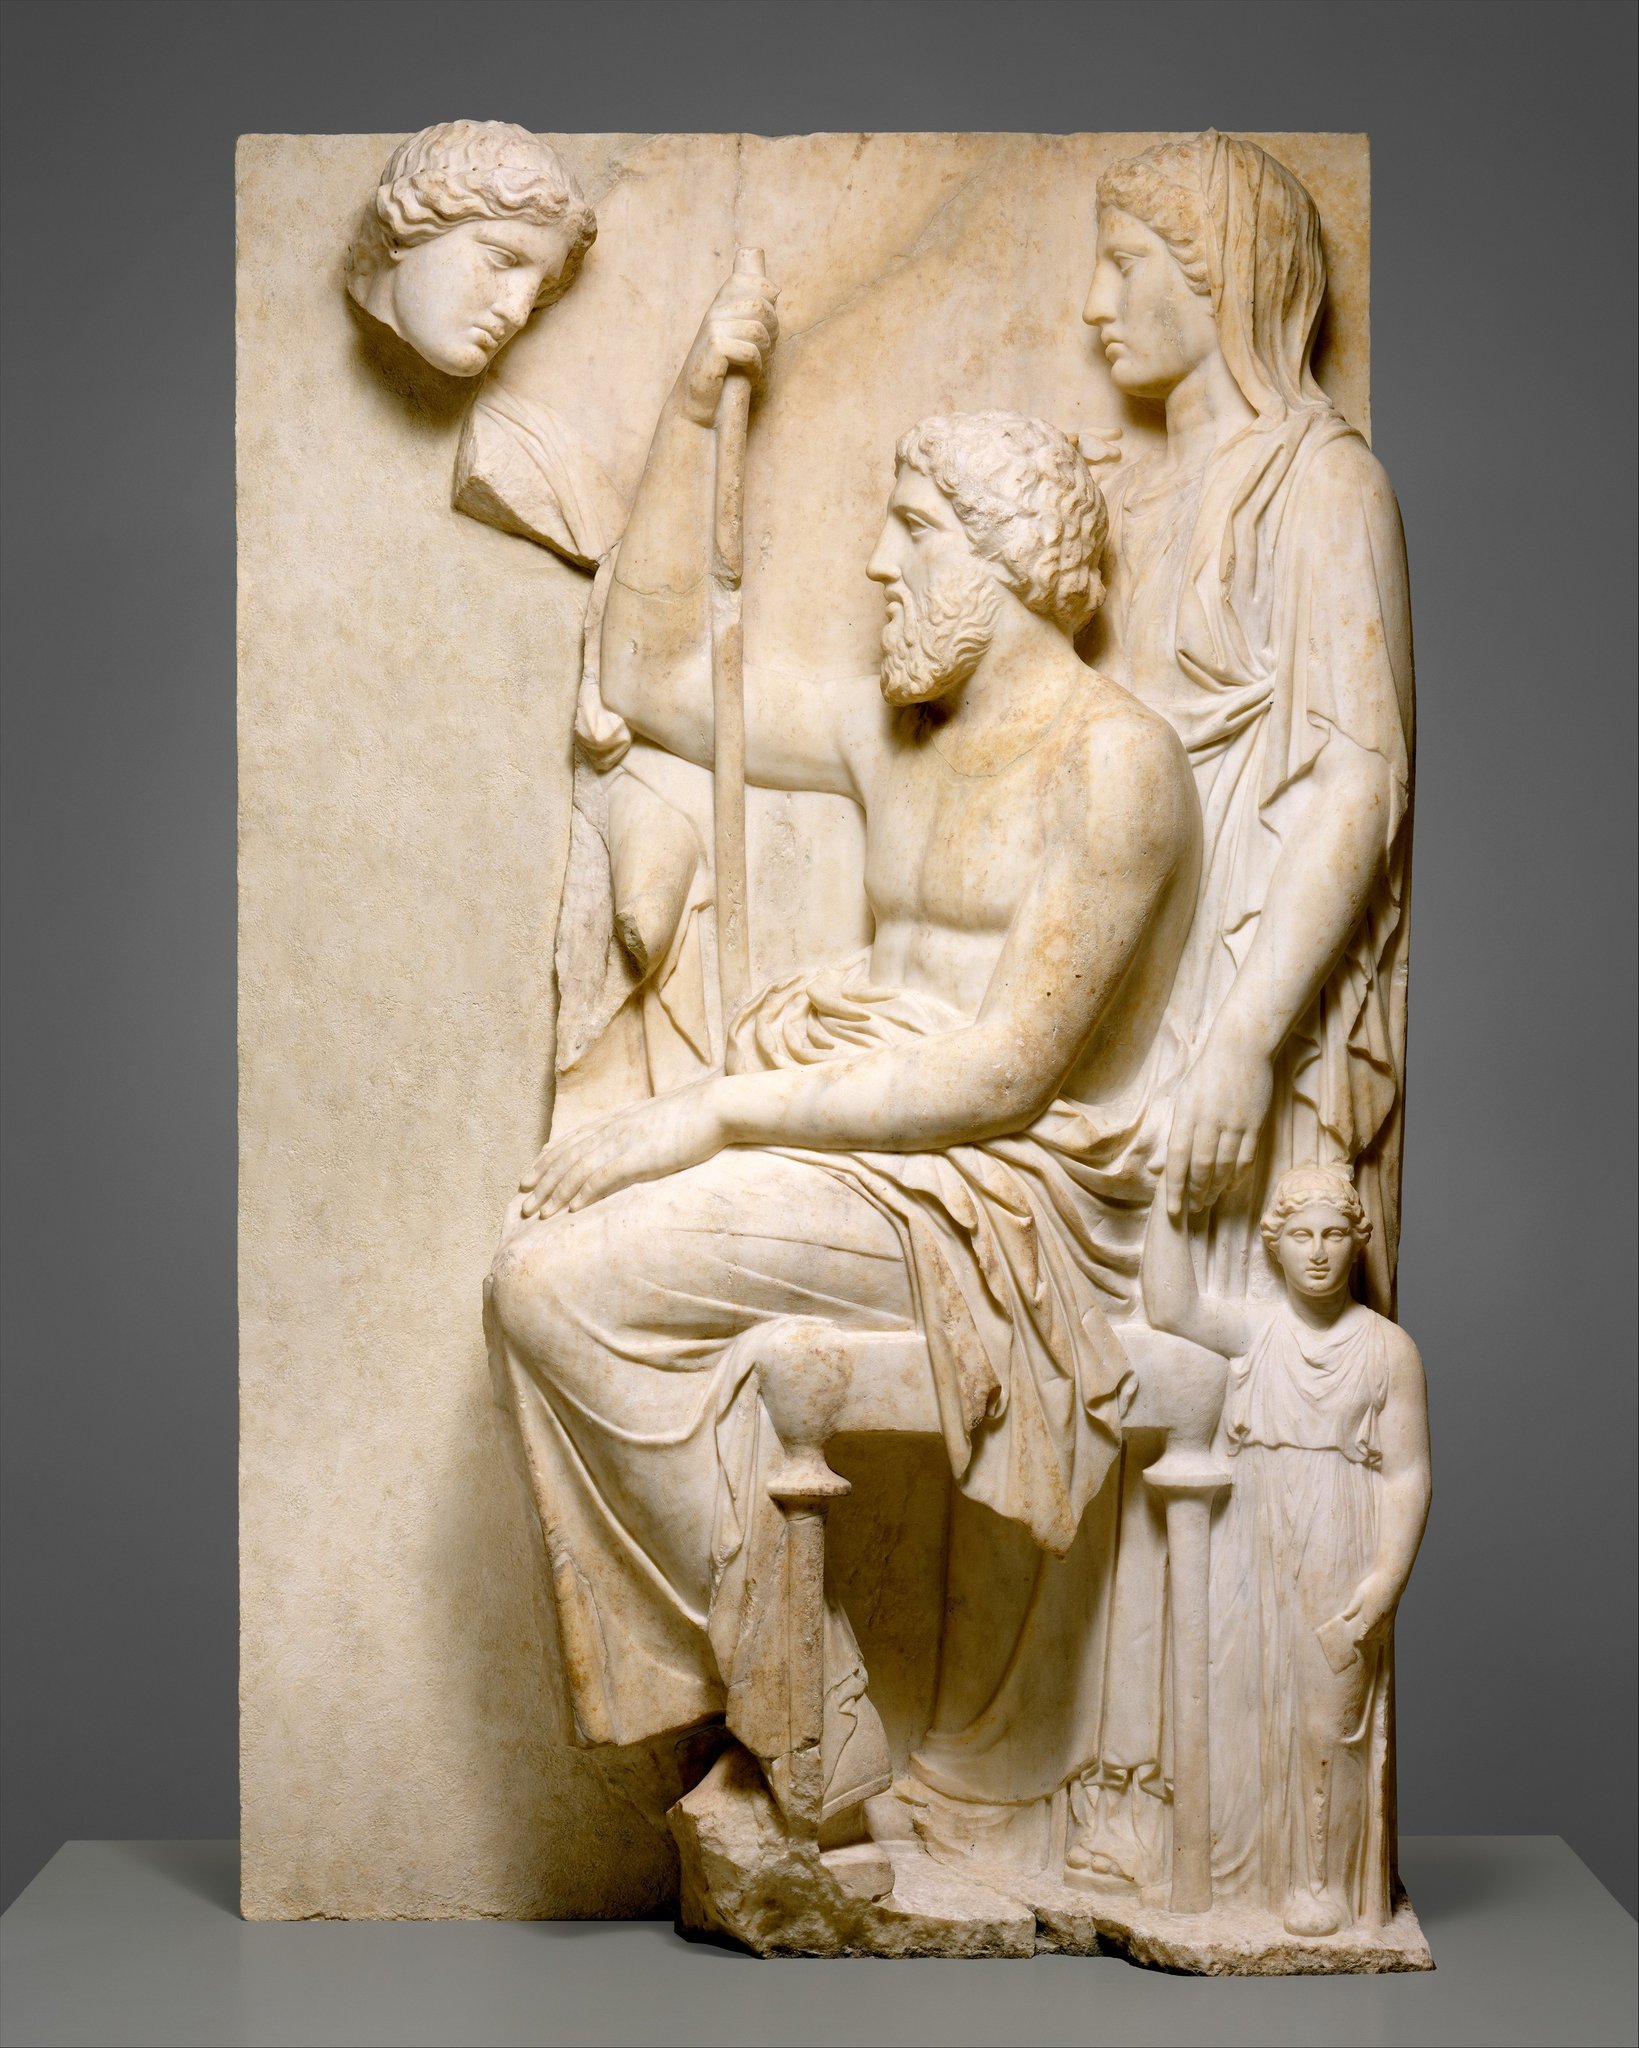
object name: grave stele with a family group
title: Marble grave stele with a family group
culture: greek, attic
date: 360 BCE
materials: marble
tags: girls,men,women,family